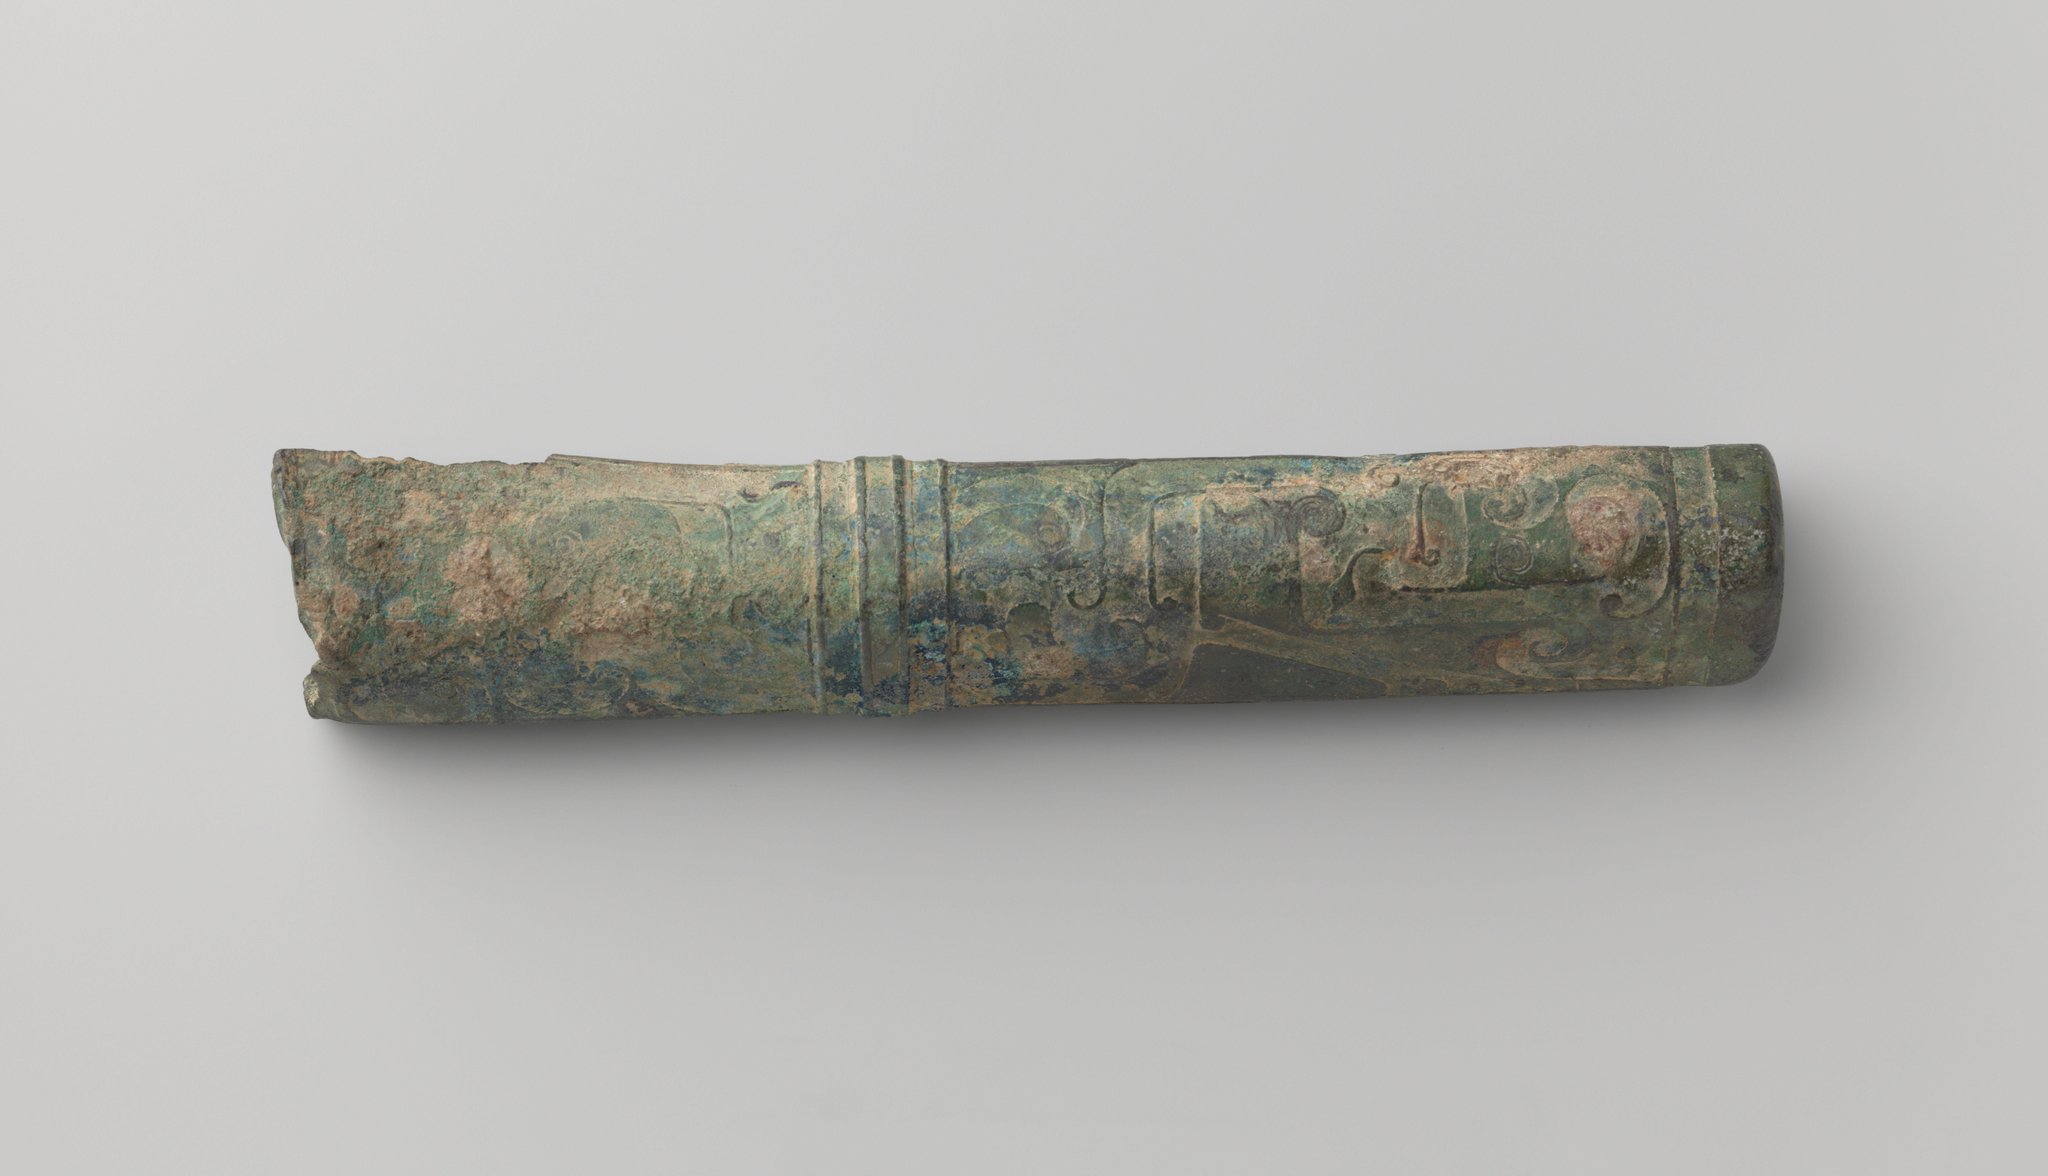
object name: fragment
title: Fragment van brons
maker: Anonymous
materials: bronze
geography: china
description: Casing of a wooden shaft, possibly part of a wagon. China. Late Eastern Zhou period (481 - 222 BC), 4th - 3rd century BC. Bronze. Verburgt bequest.